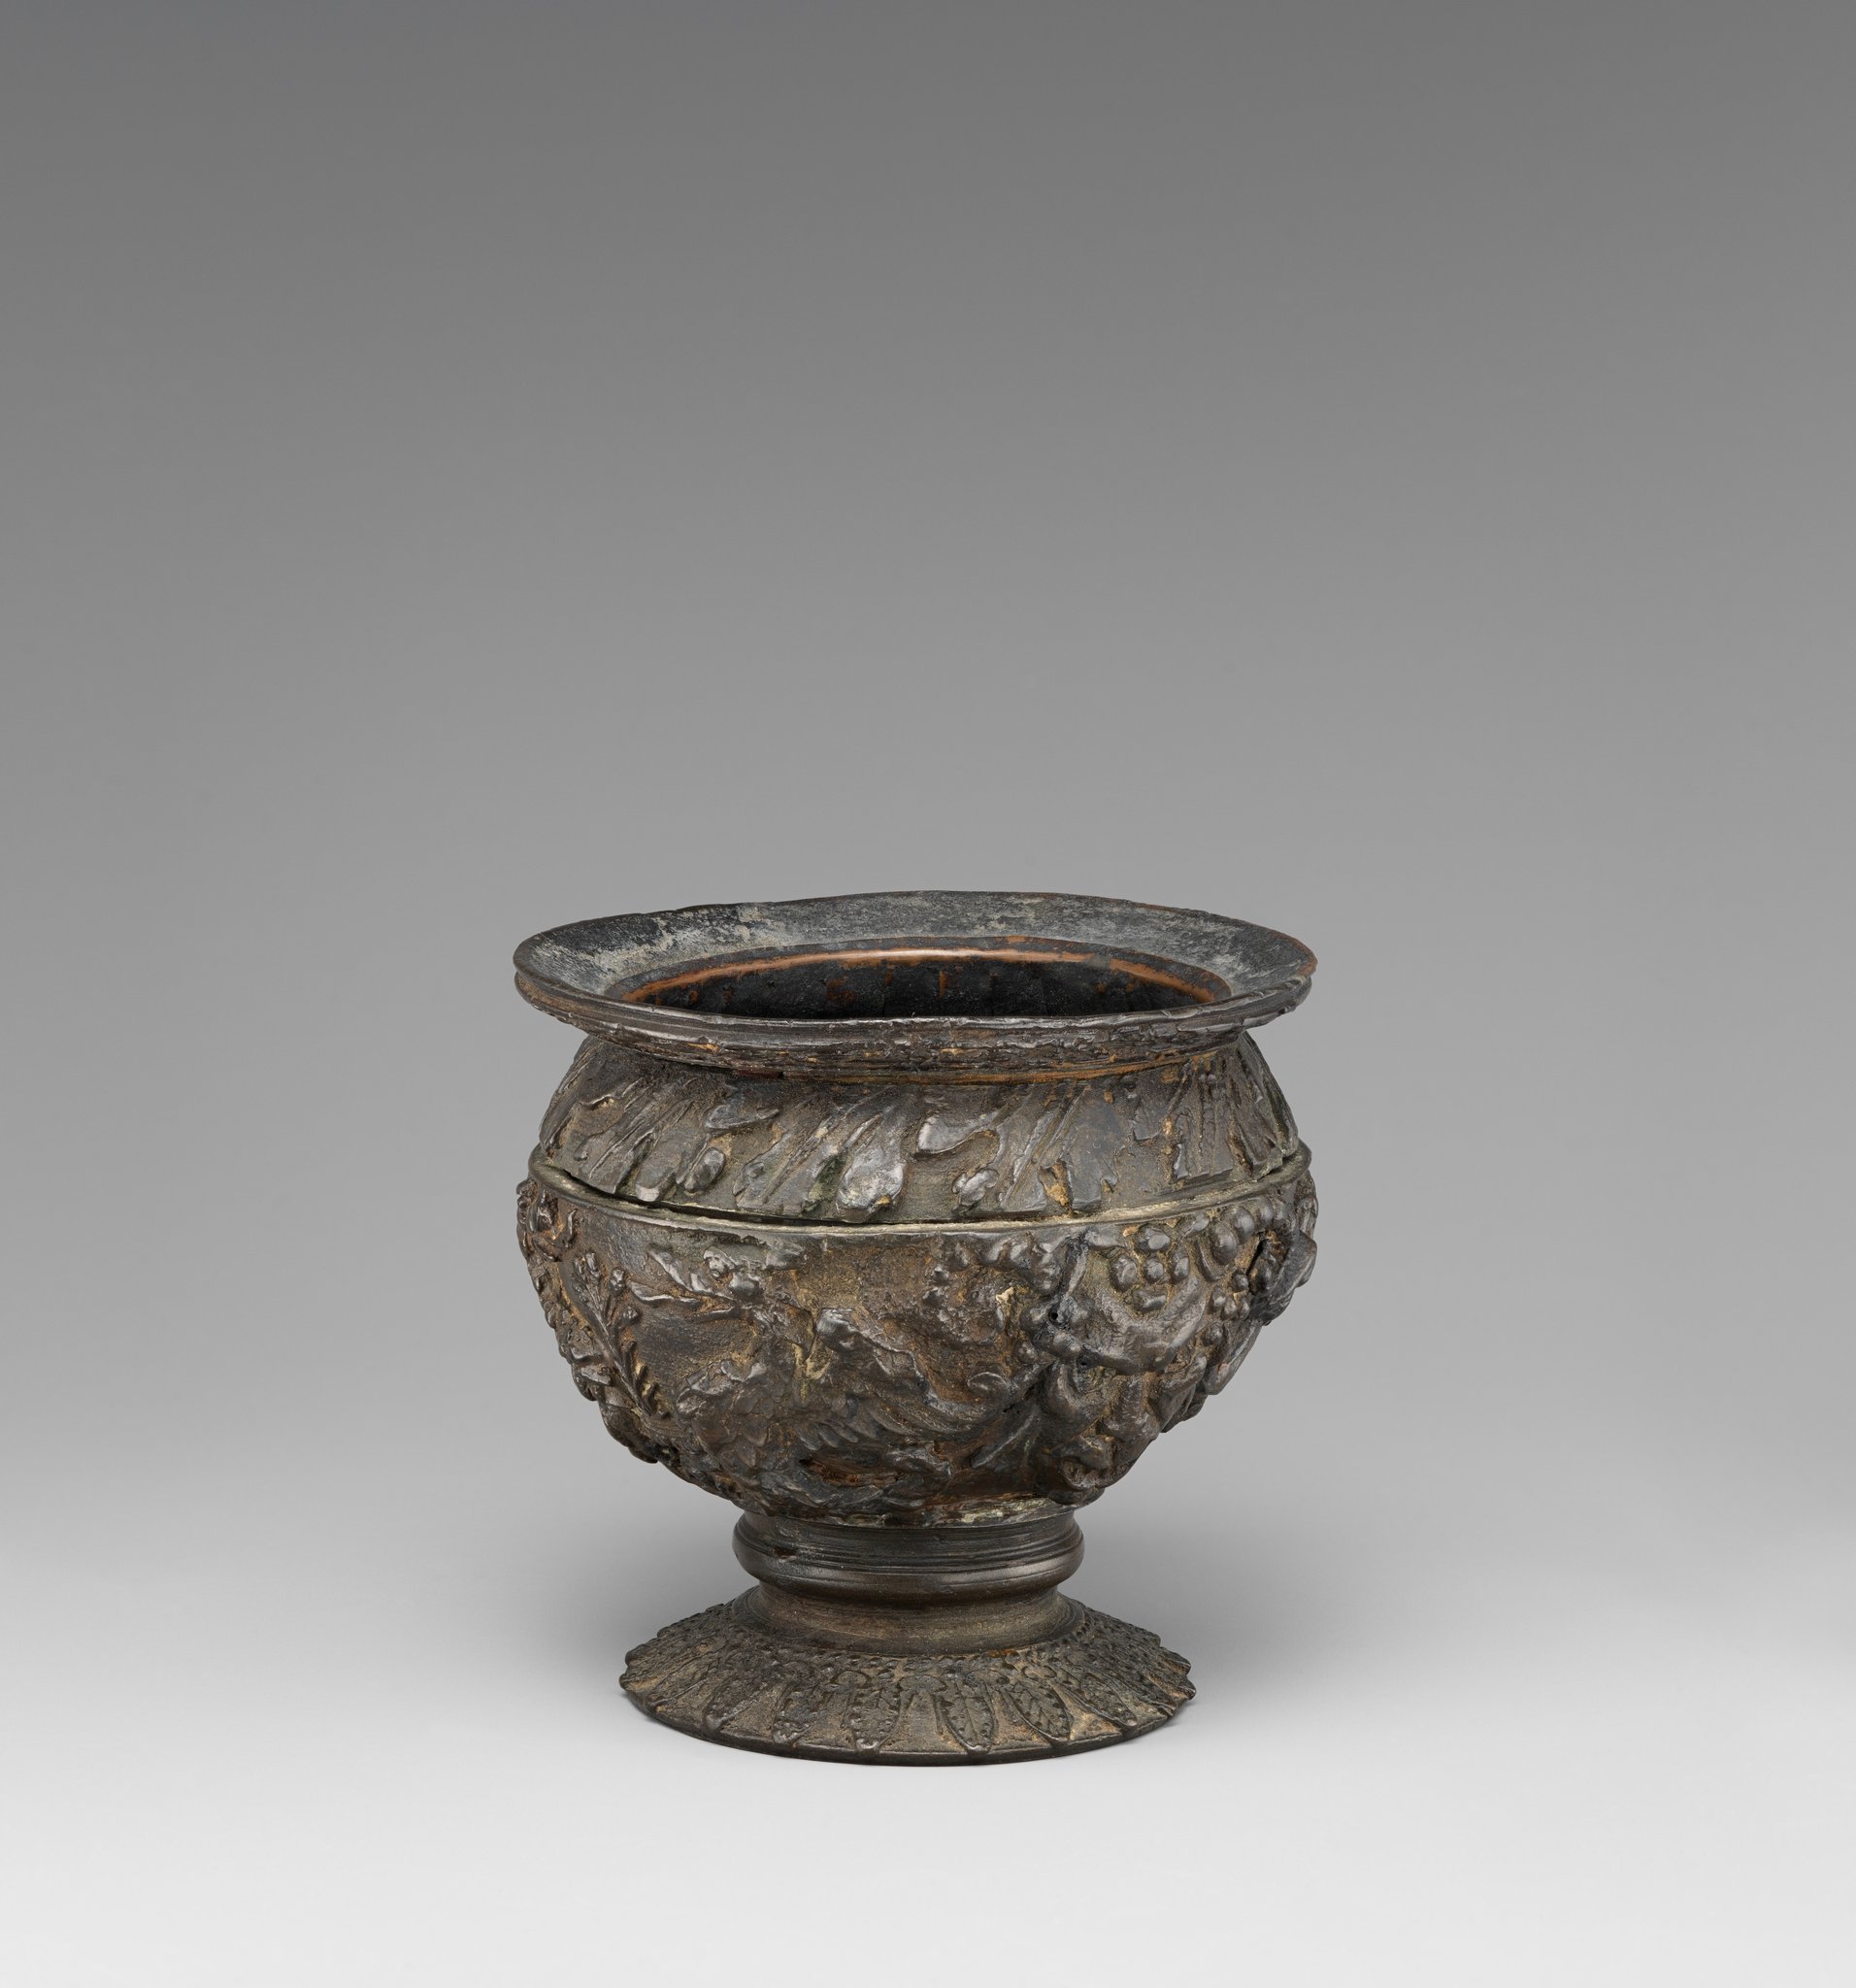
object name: inkwell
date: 1500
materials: bronze